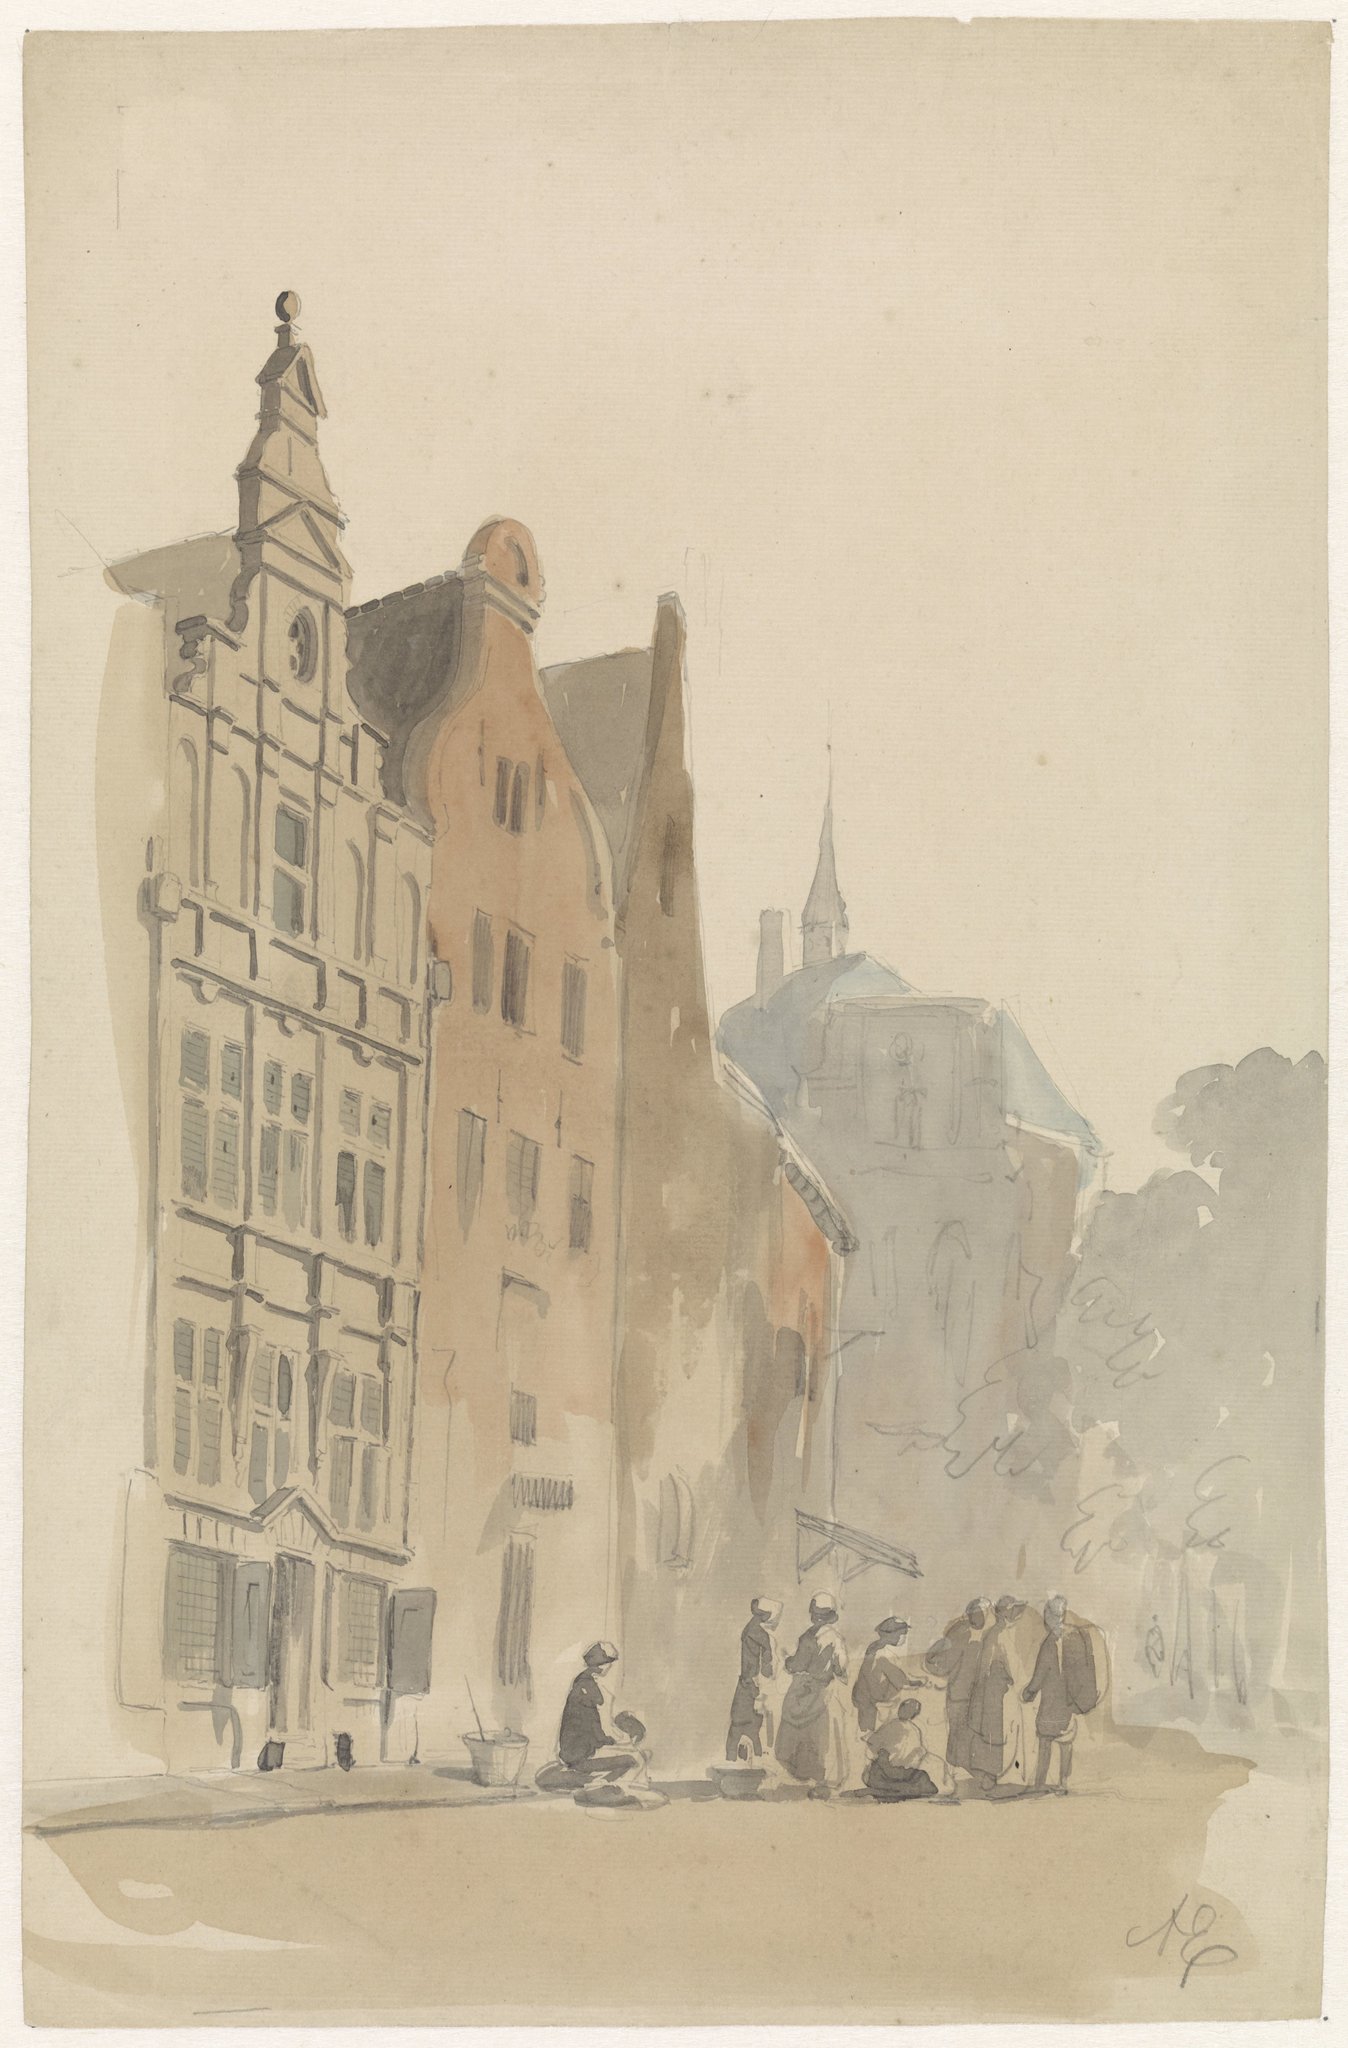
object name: drawing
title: Ronde Lutherse kerk en enige huizen te Amsterdam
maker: adrianus eversen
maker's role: draughtsman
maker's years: 1818-1897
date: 1828-1897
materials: paper, pencil, watercolor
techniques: brush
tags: church (exterior), public road